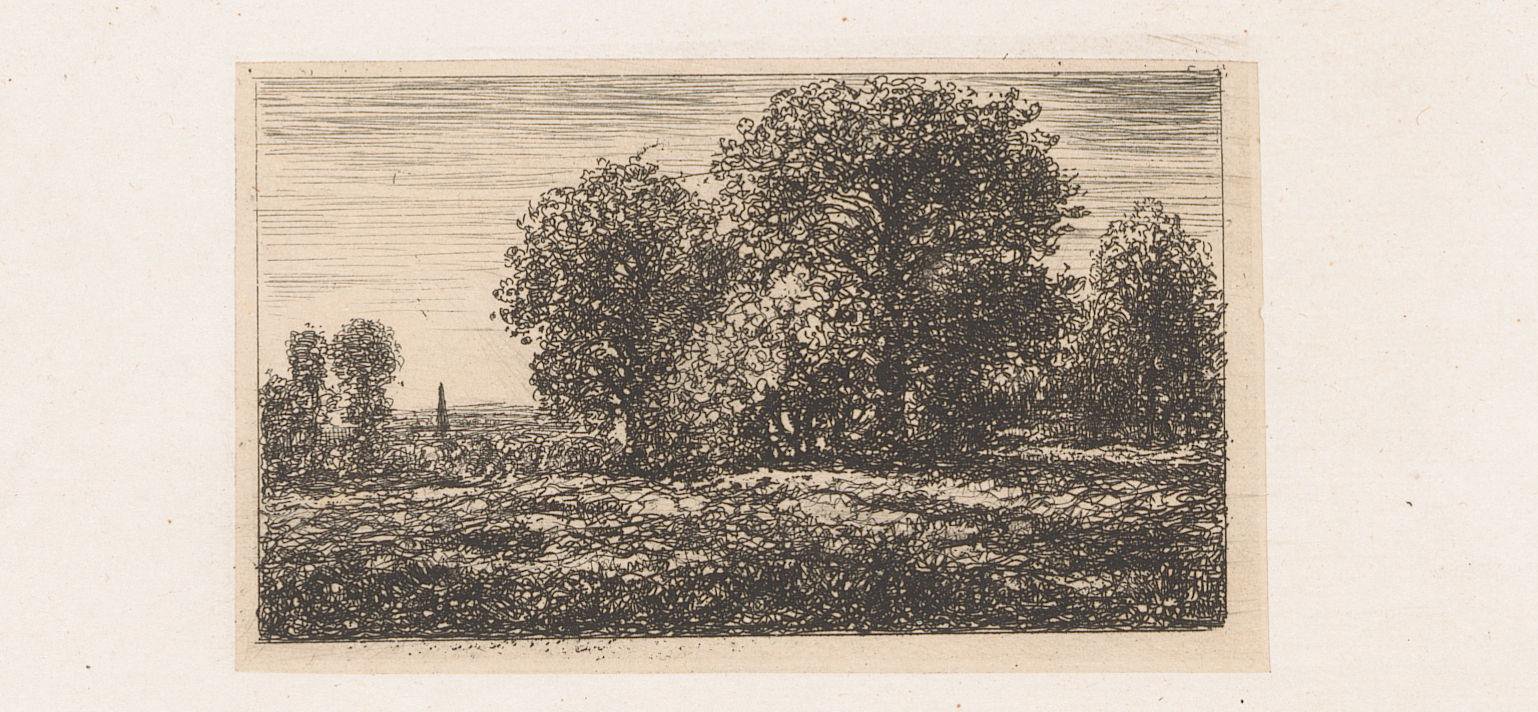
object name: print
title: Bomen in een landschap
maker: jean alexis achard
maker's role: print maker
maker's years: 1807-1884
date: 1817-1884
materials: paper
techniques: etching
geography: france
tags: trees, landscapes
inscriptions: collector's mark: Lugt 2228, inscription: ‘2me état’